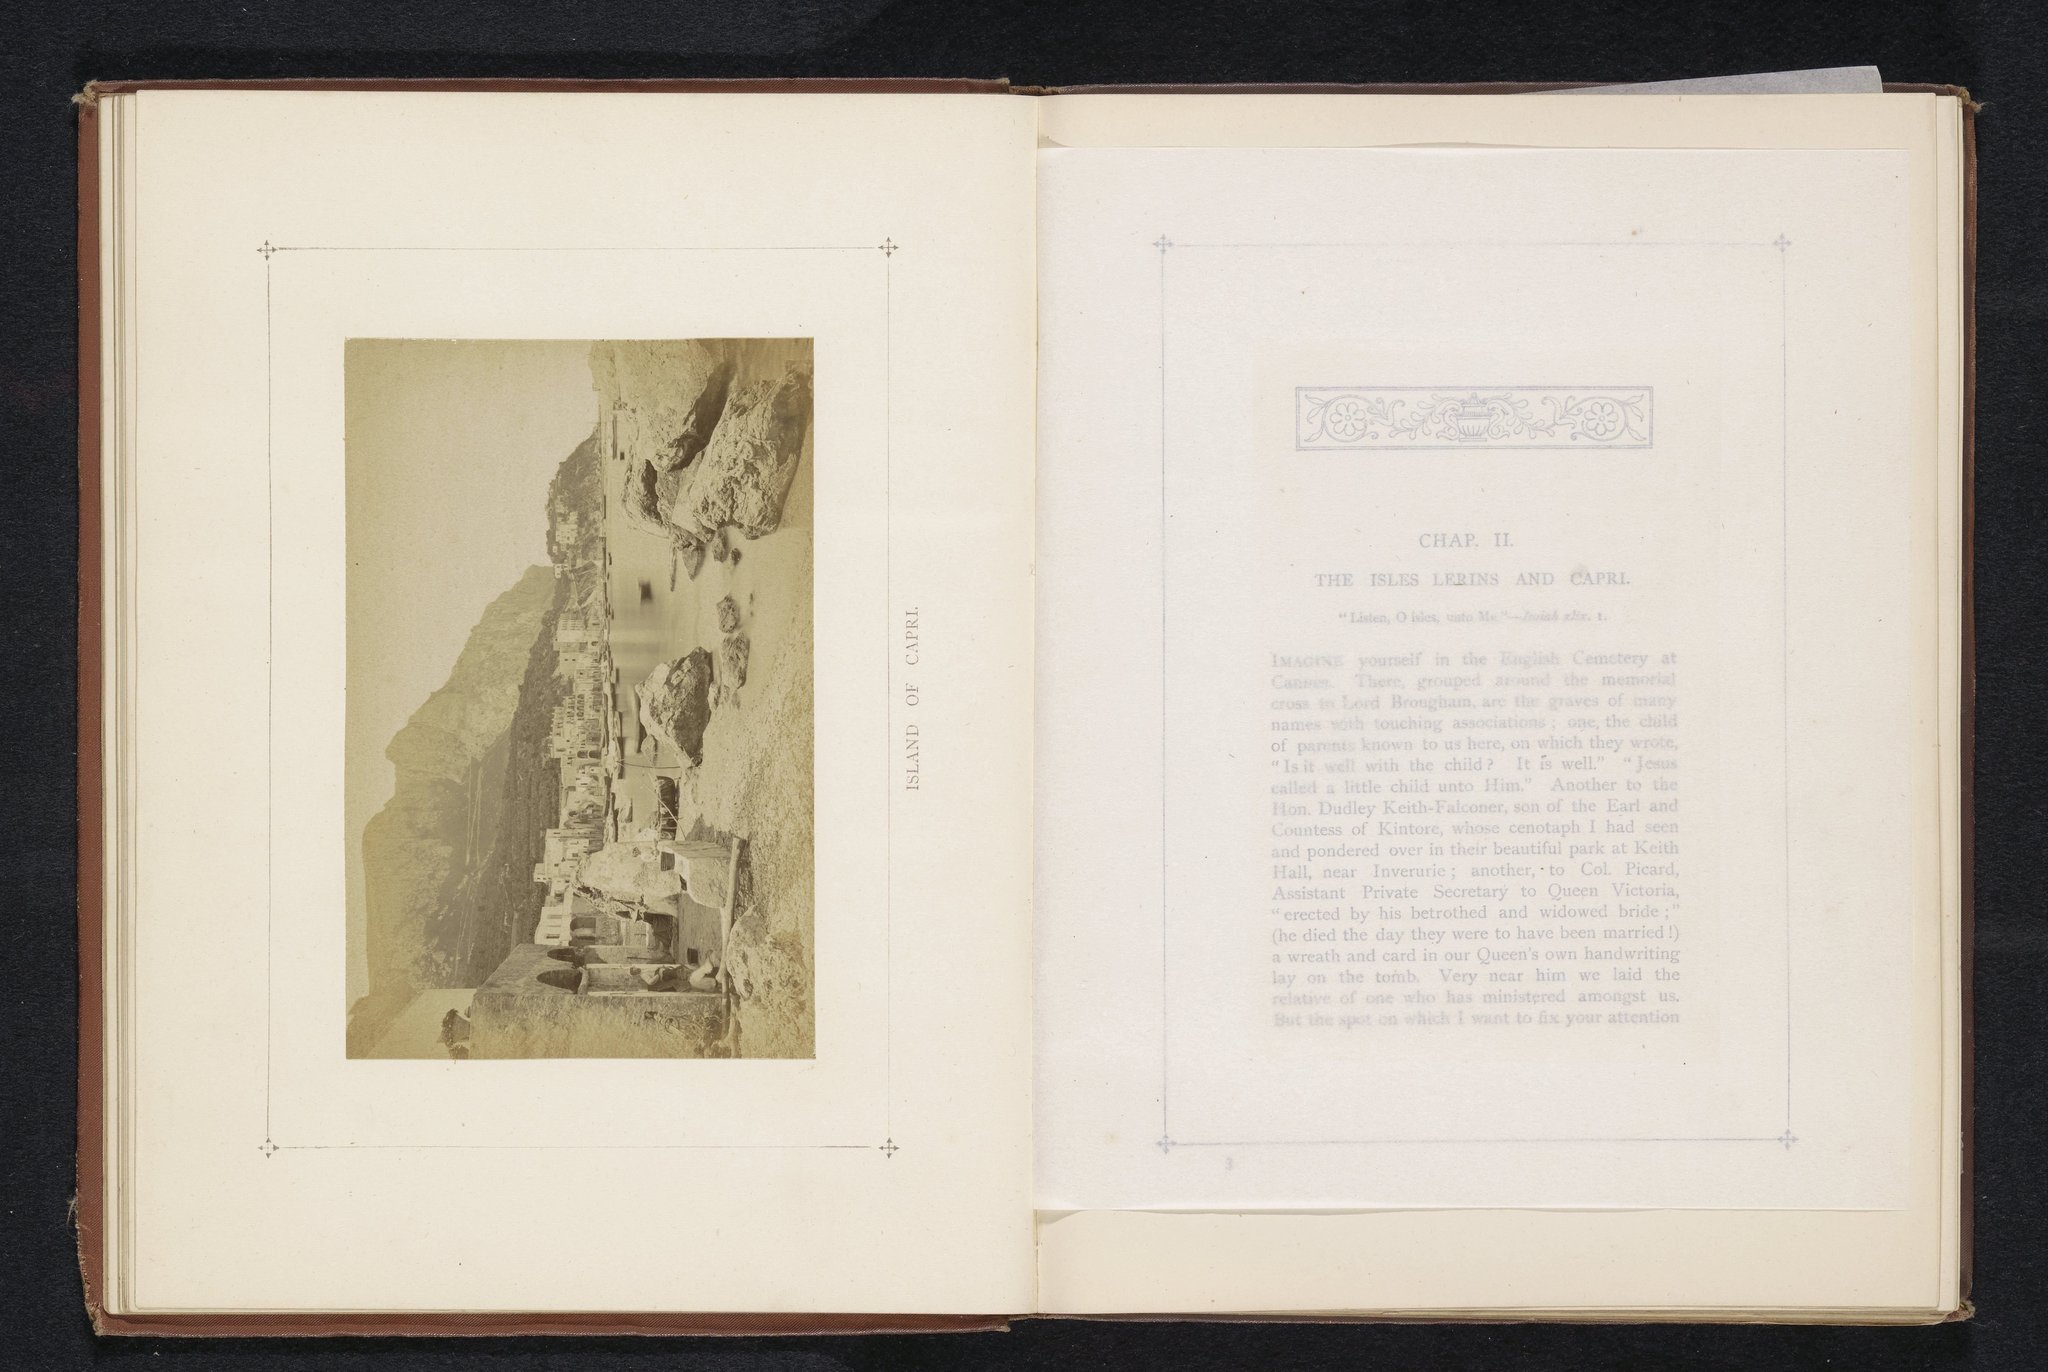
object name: photograph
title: Island of Capri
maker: Anonymous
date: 1872-1882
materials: photographic support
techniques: albumen print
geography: capri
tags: island, city-view in general; 'veduta', rocky coast, capri